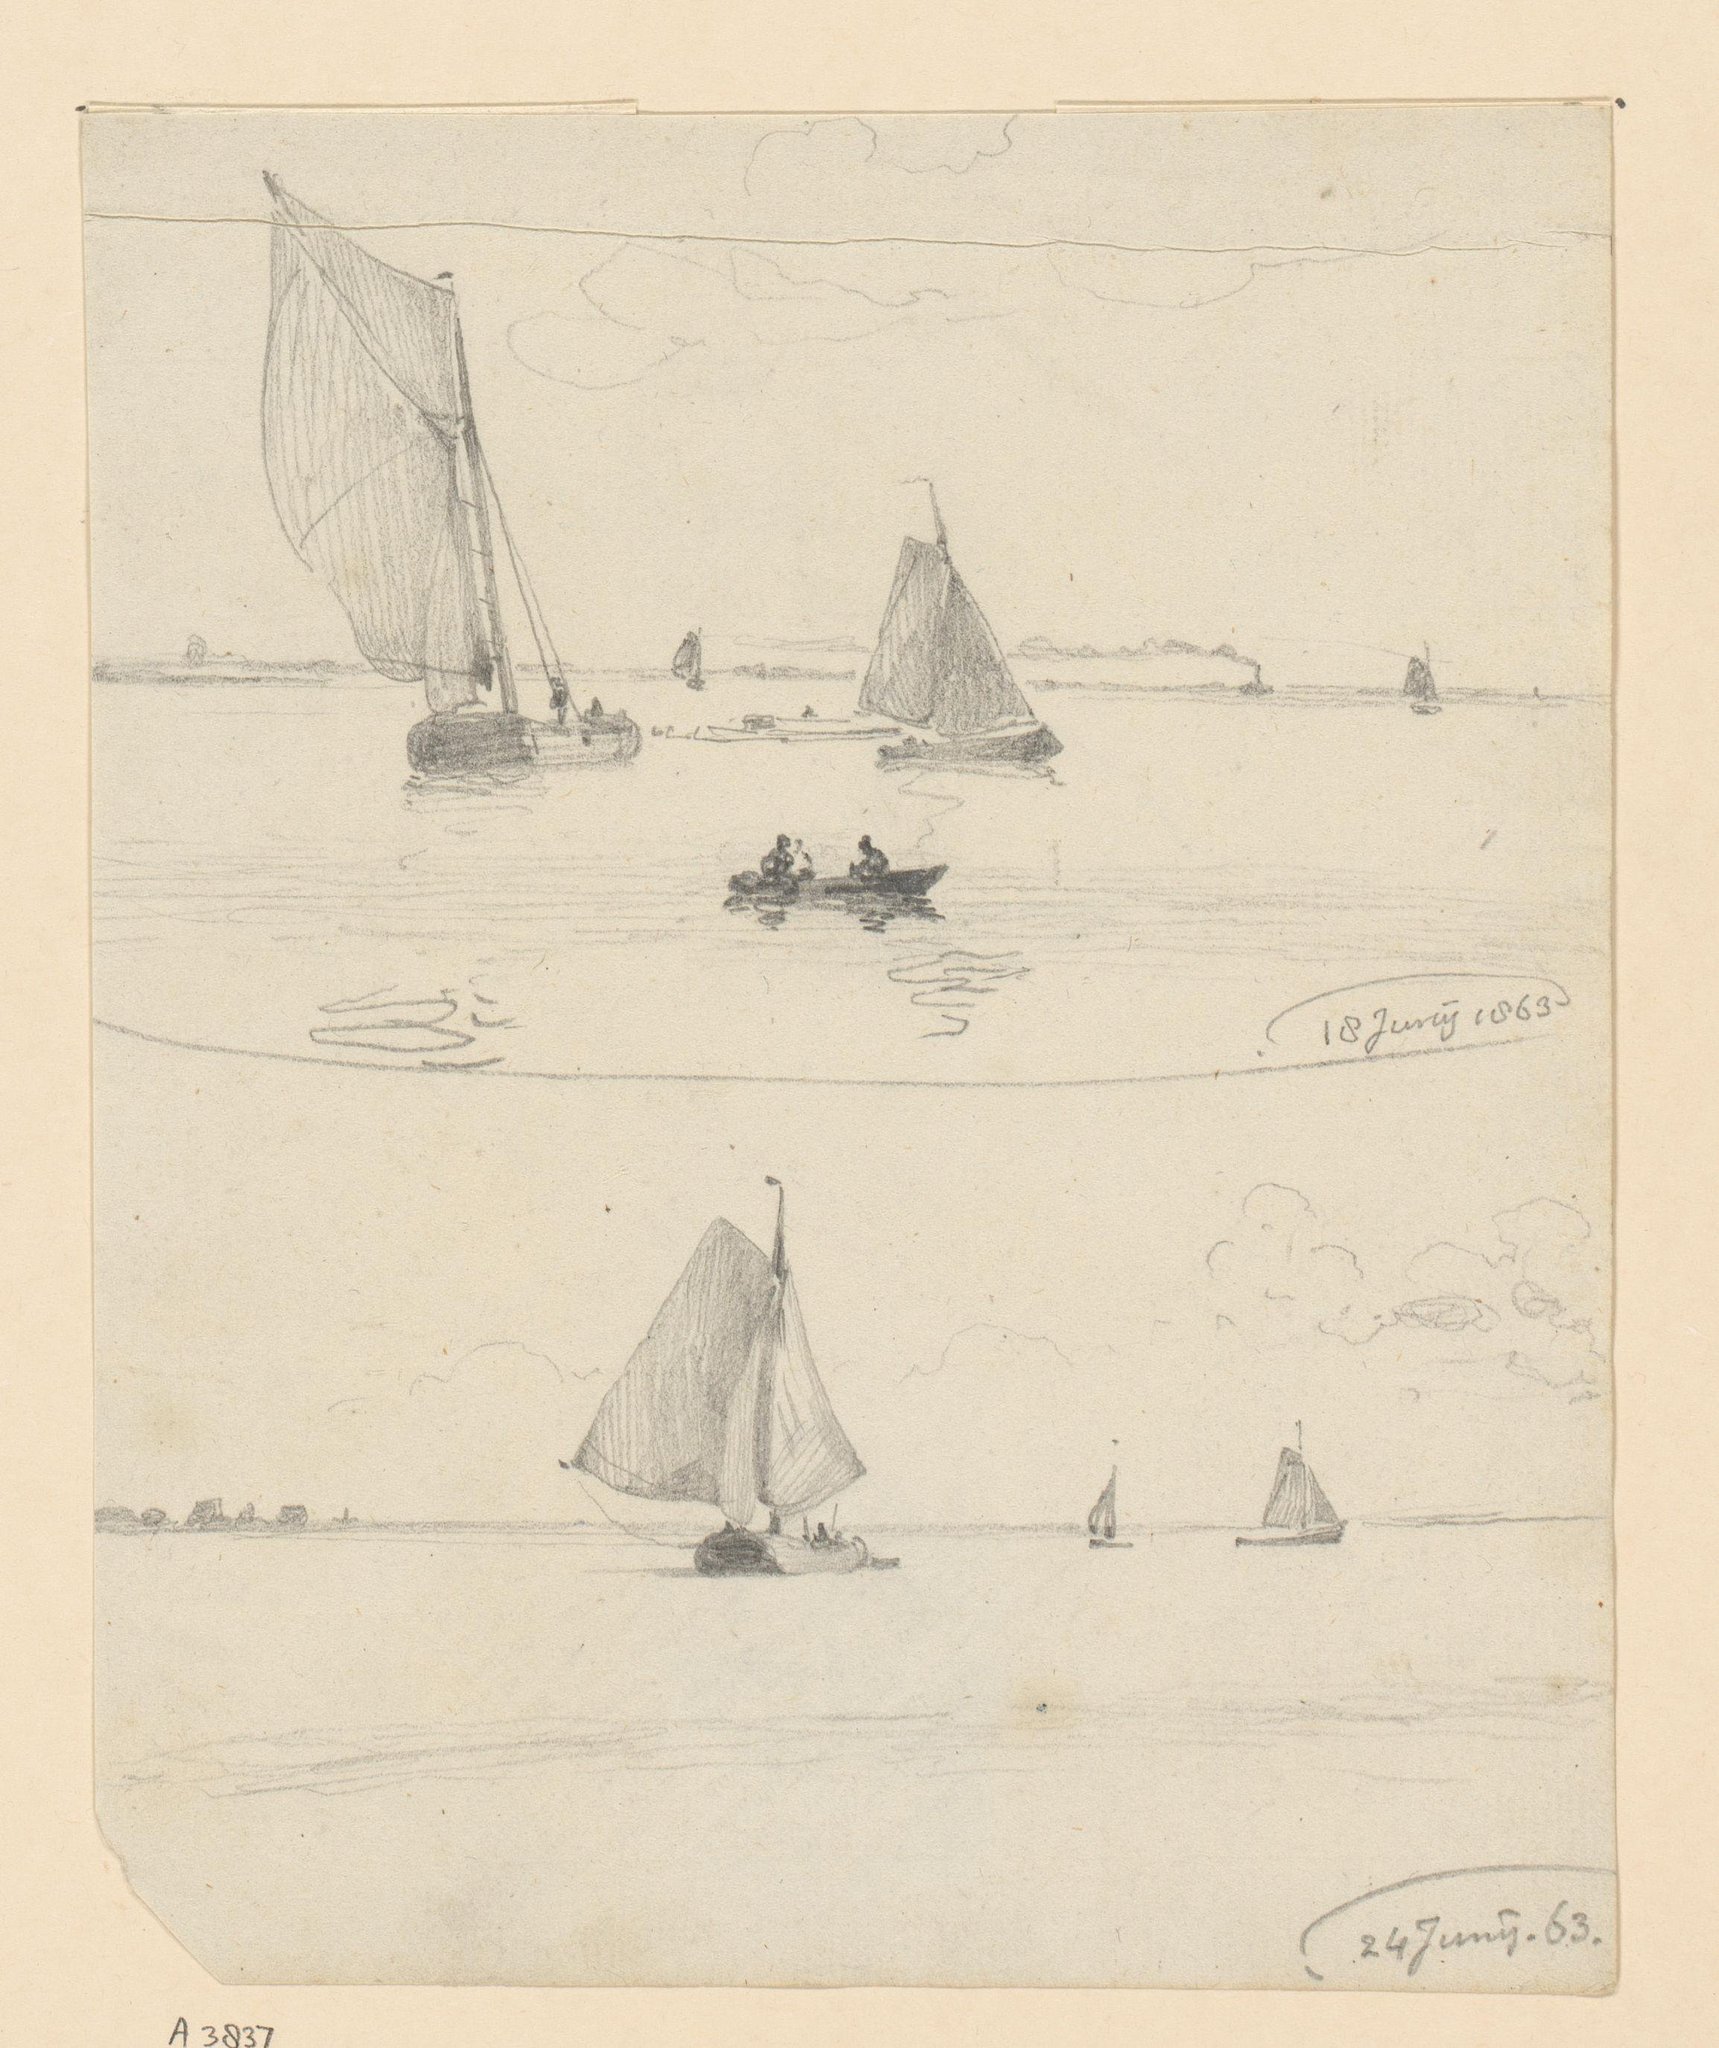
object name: drawing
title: Twee schetsen met vissersboten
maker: willem anthonie van deventer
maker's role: draughtsman, painter, print maker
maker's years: 1824-1893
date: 1863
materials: paper, pencil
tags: sailing-ship, sailing-boat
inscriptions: date: ‘18 Juny 63’, date: ‘24 Juny.63’